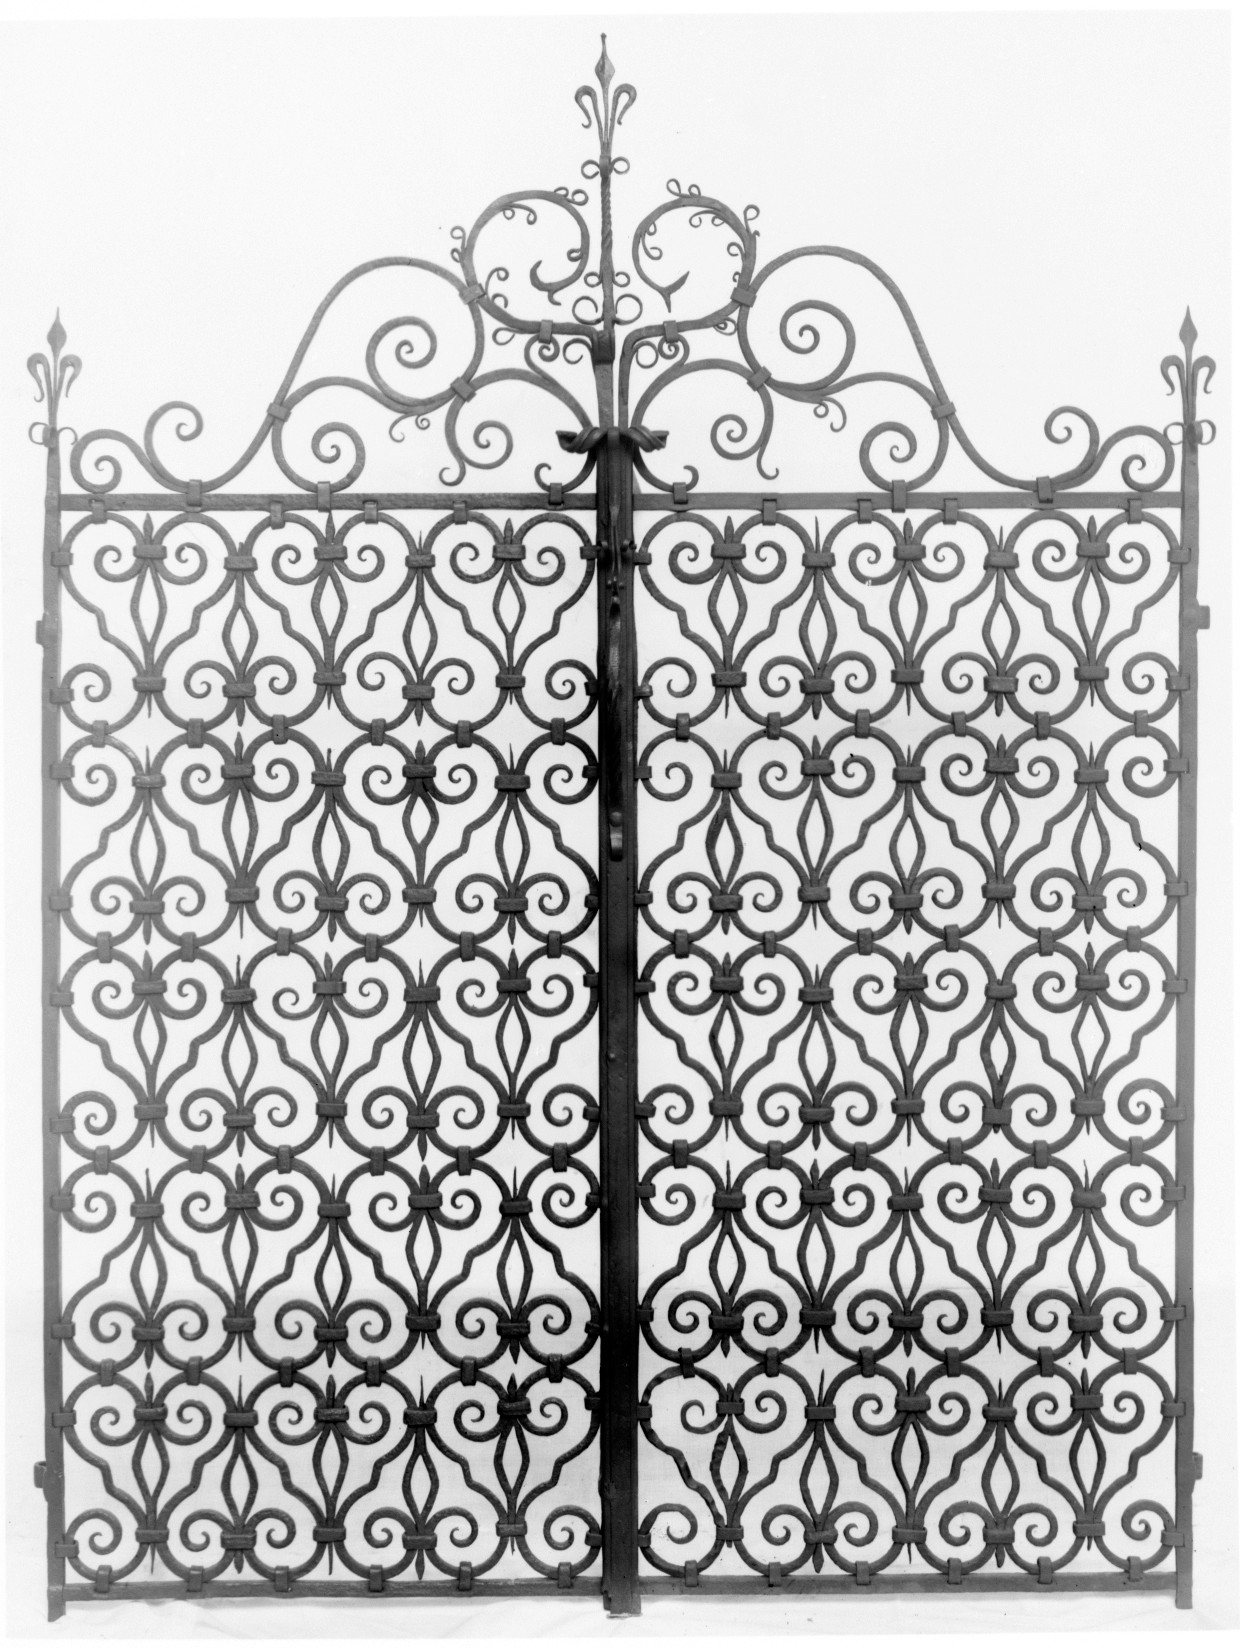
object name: gate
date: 1601-1700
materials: iron